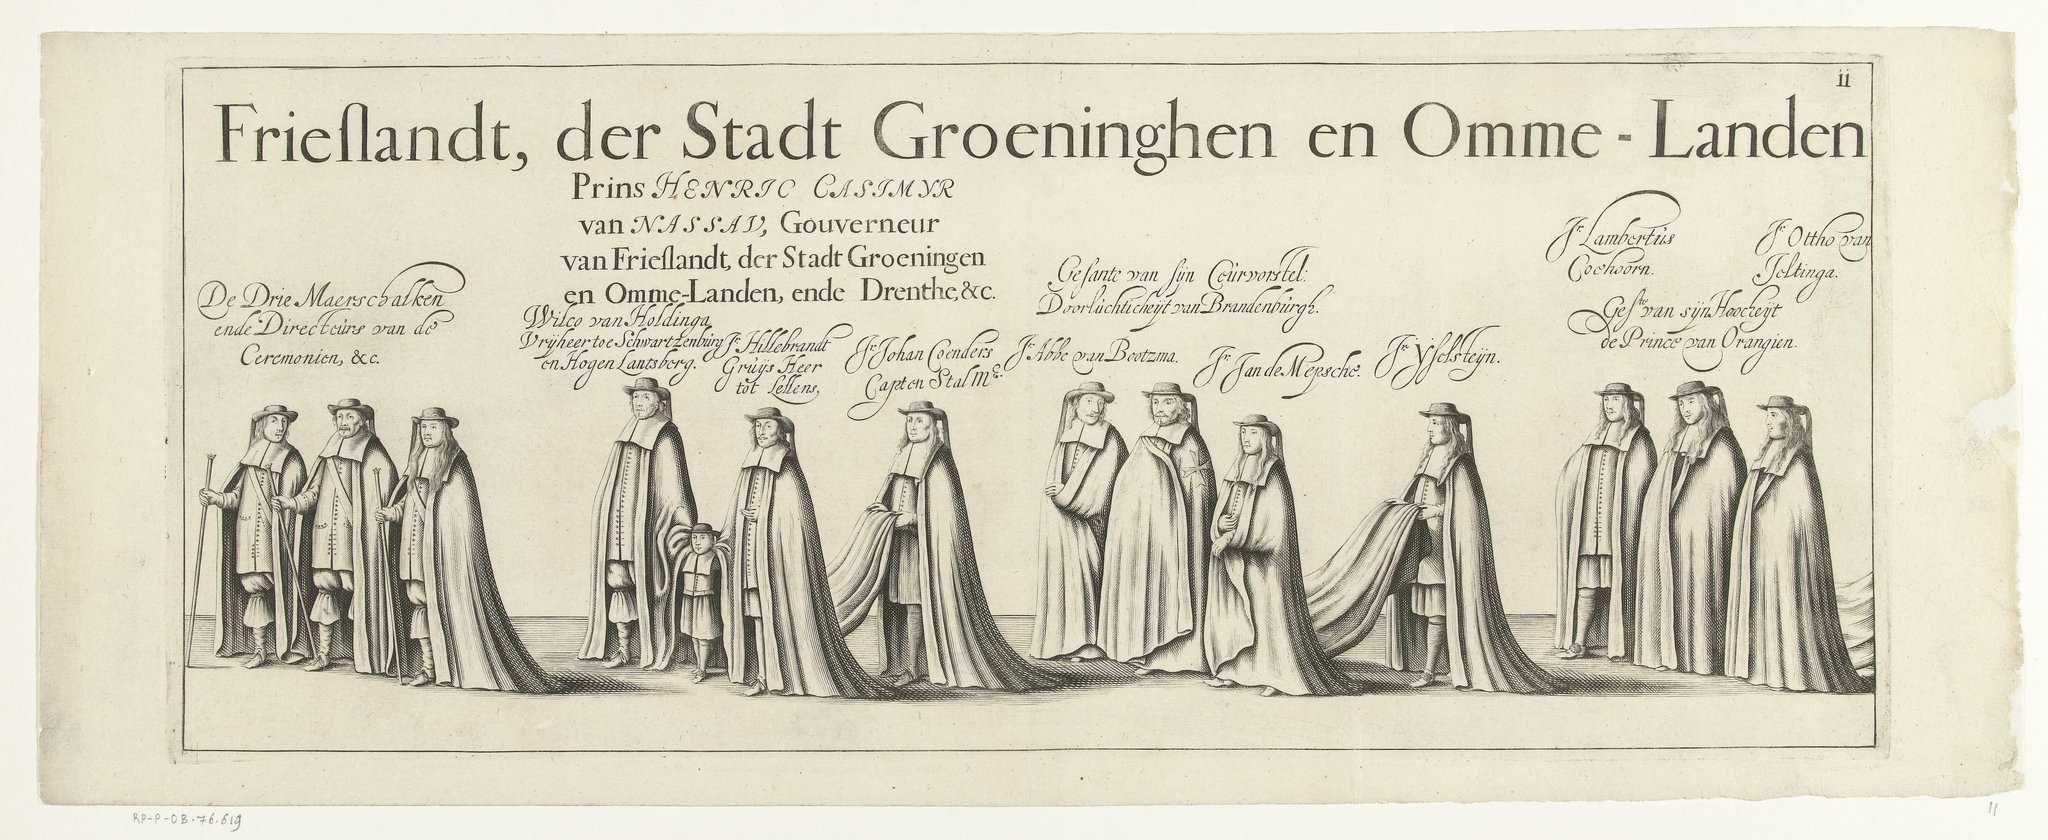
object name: print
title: Rouw-Staetelijcke Lijk-pracht in de Uyt-Vaert en Begraefenisse van het ont-zielde Lichaem van (...) Wilhelm Frederich (...) Overleden binnen Leeuwarden (...) den een-en-twintichsten October, MDCLXIV. en aldaer in 't Choor van de Jacobijner Kerck, den vyfthienden december MDCLXIV. Oude Stijl (...)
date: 1666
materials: paper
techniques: engraving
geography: leeuwarden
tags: arnhem, cortege, funeral procession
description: Begrafenisoptocht van Willem Frederik, graaf van Nassau-Dietz, in Leeuwarden op 6 januari 1665. Deel van de begrafenisstoet. Plaat nr. 11 in een ensemble van 25 ongemonteerde genummerde platen en twee tekstbladen die samen een lange fries vormen.